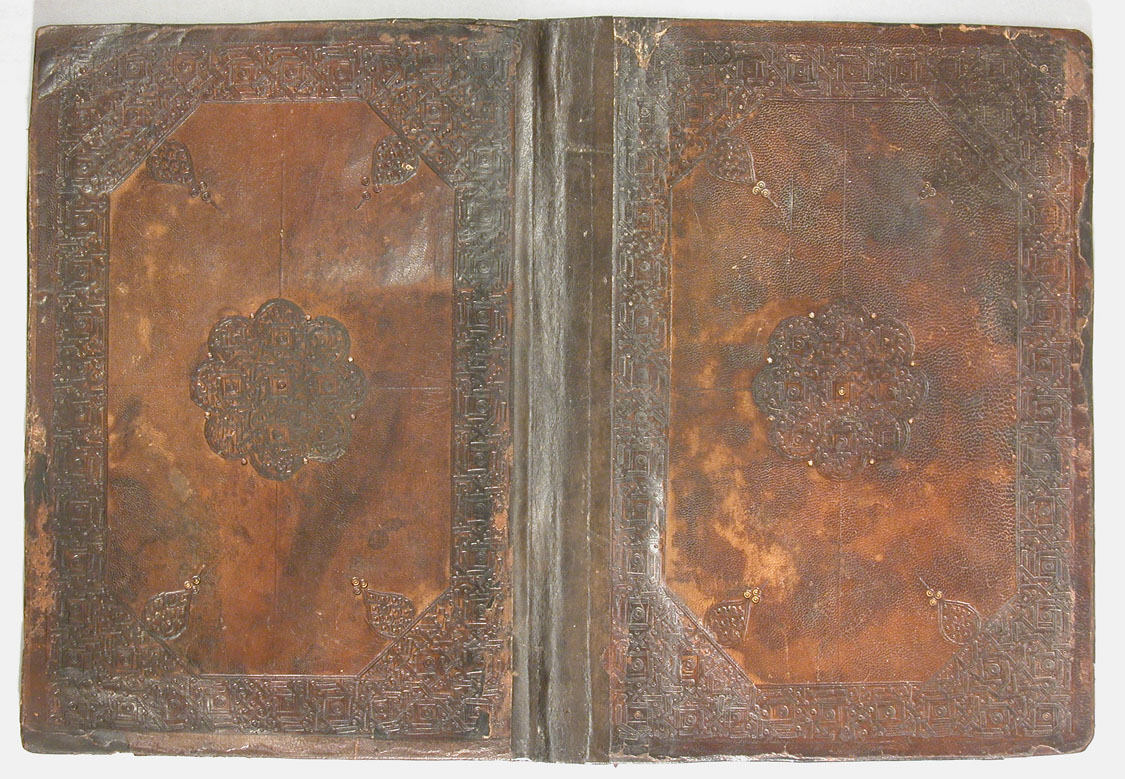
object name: bookbinding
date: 1301-1400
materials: leather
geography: north africa